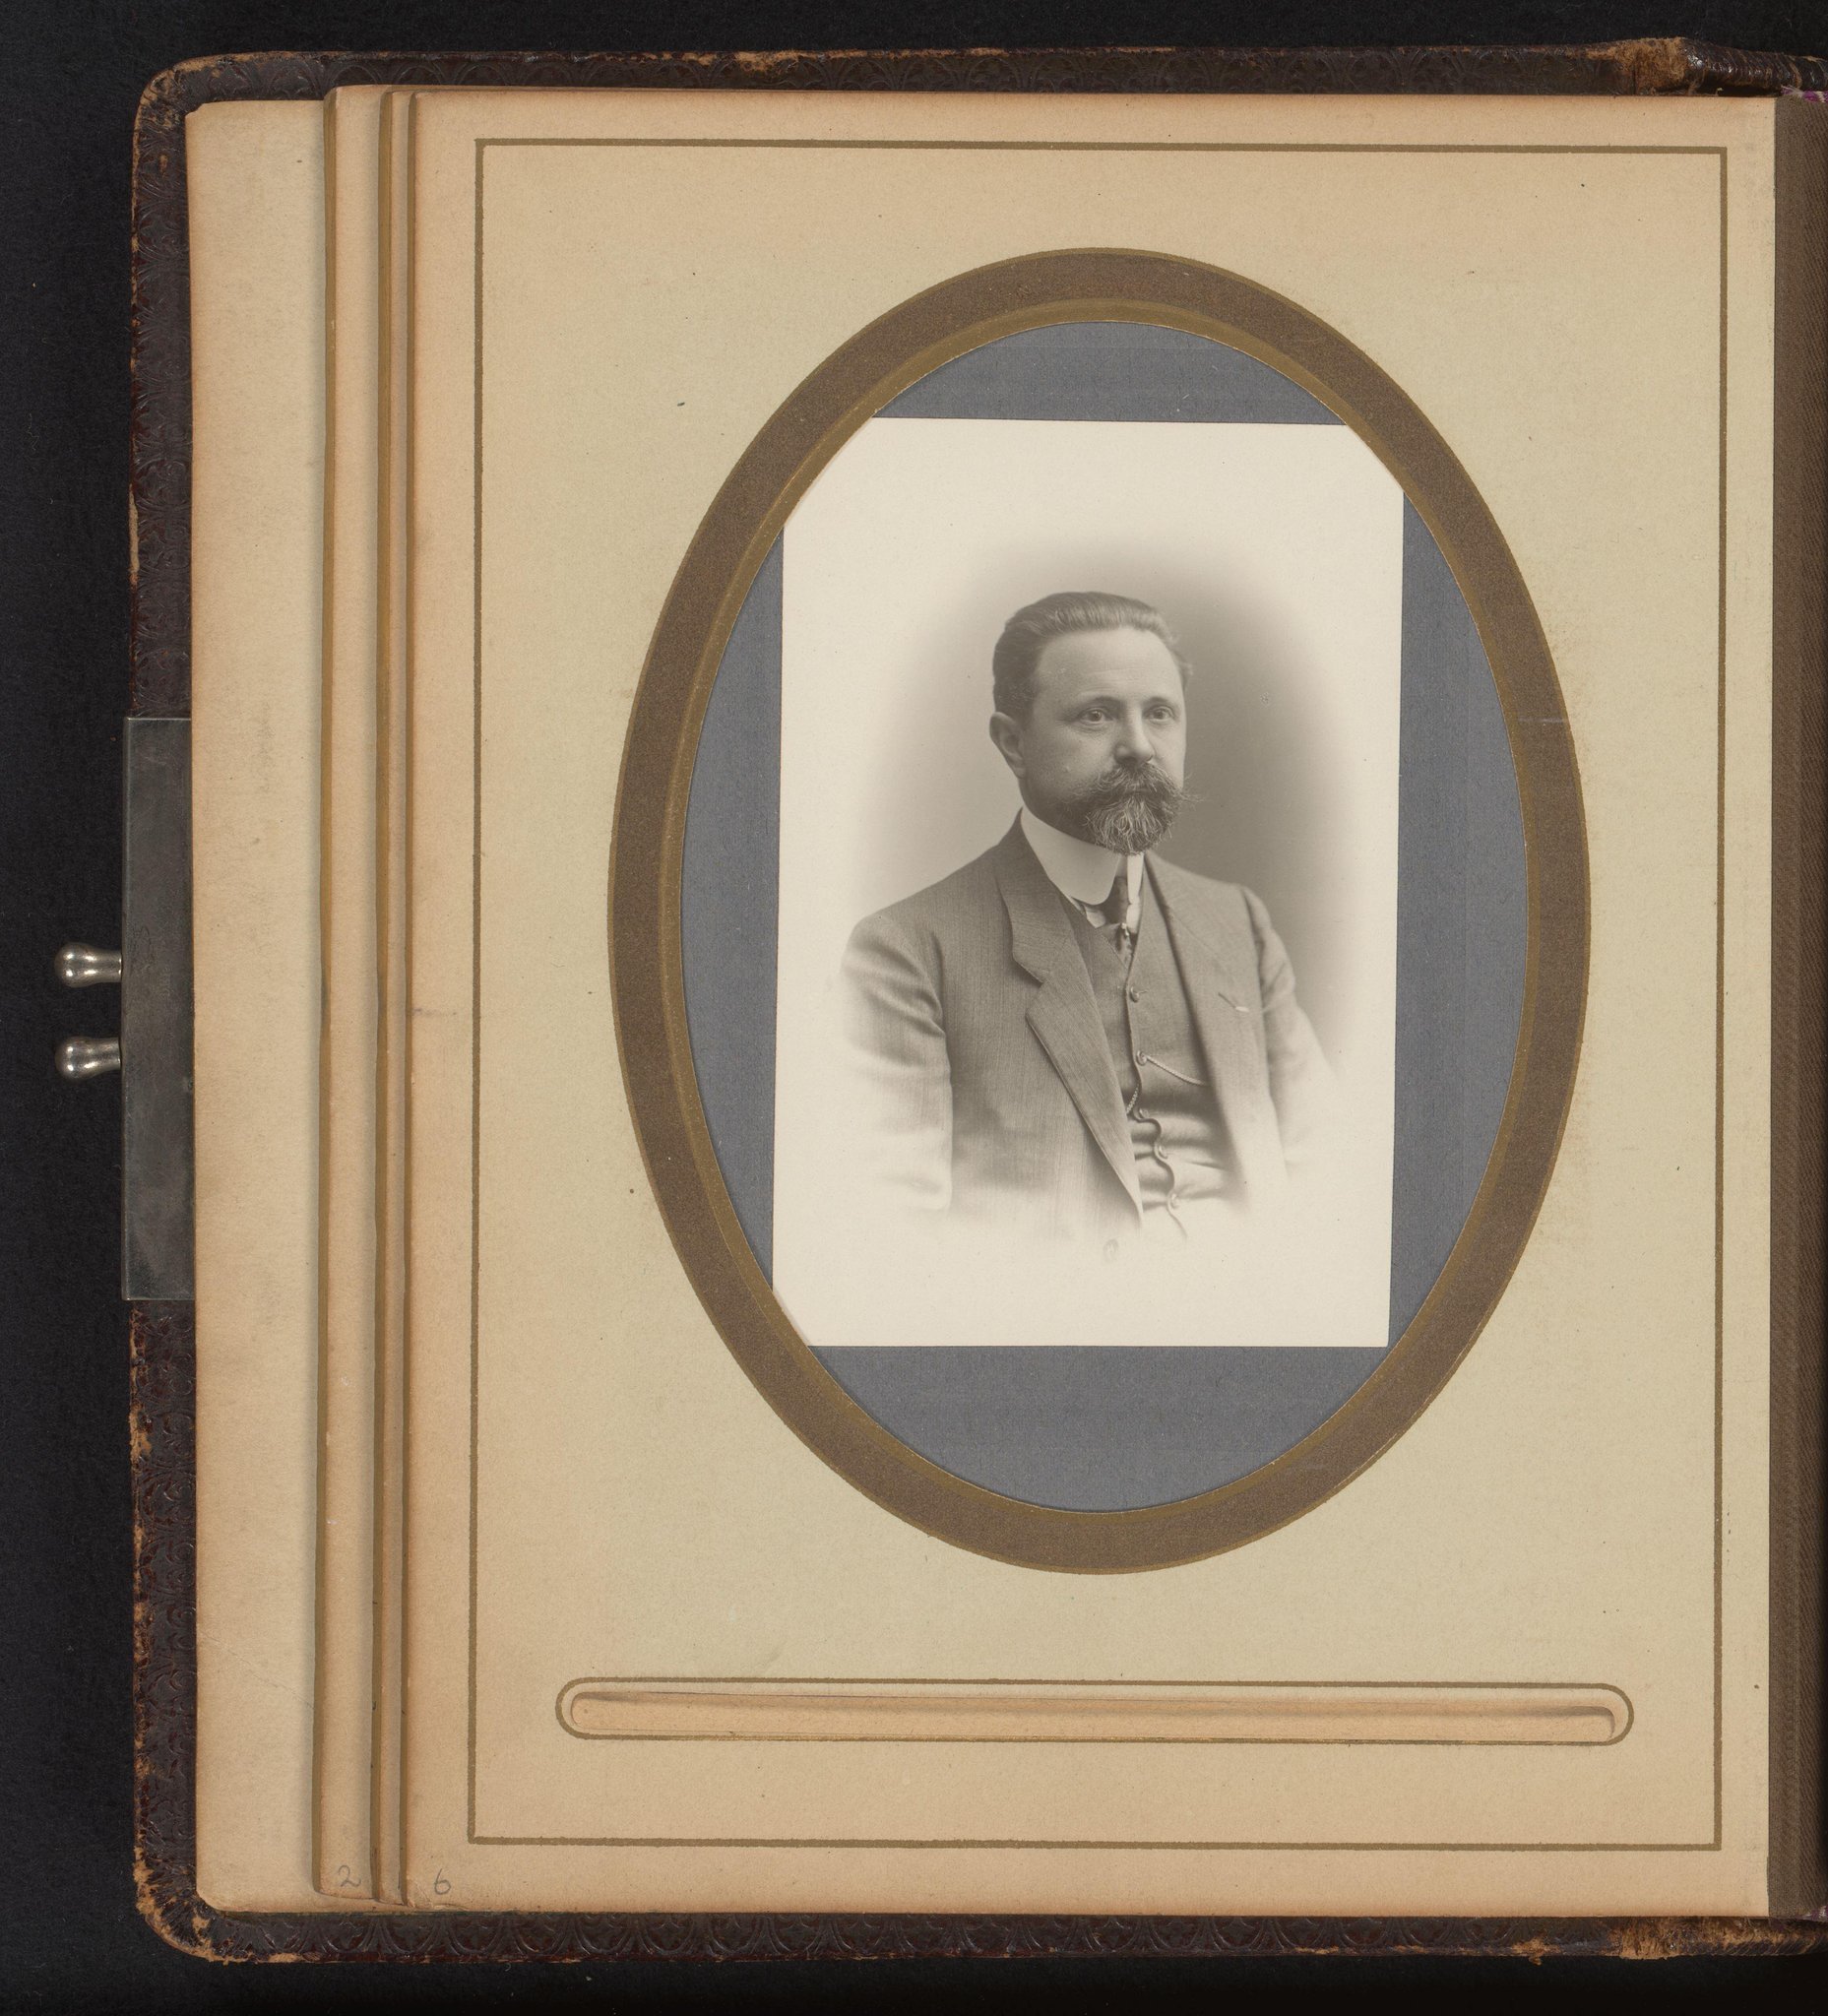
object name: photograph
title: Portret van een man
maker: stéphano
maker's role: fotograaf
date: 1895-1920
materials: cardboard, photographic support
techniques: matte daylight collodion silver print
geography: paris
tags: historical persons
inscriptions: inscription: ‘Stéphano/ Médaille d'Argent, Paris./ 60. Rue de Passy.’